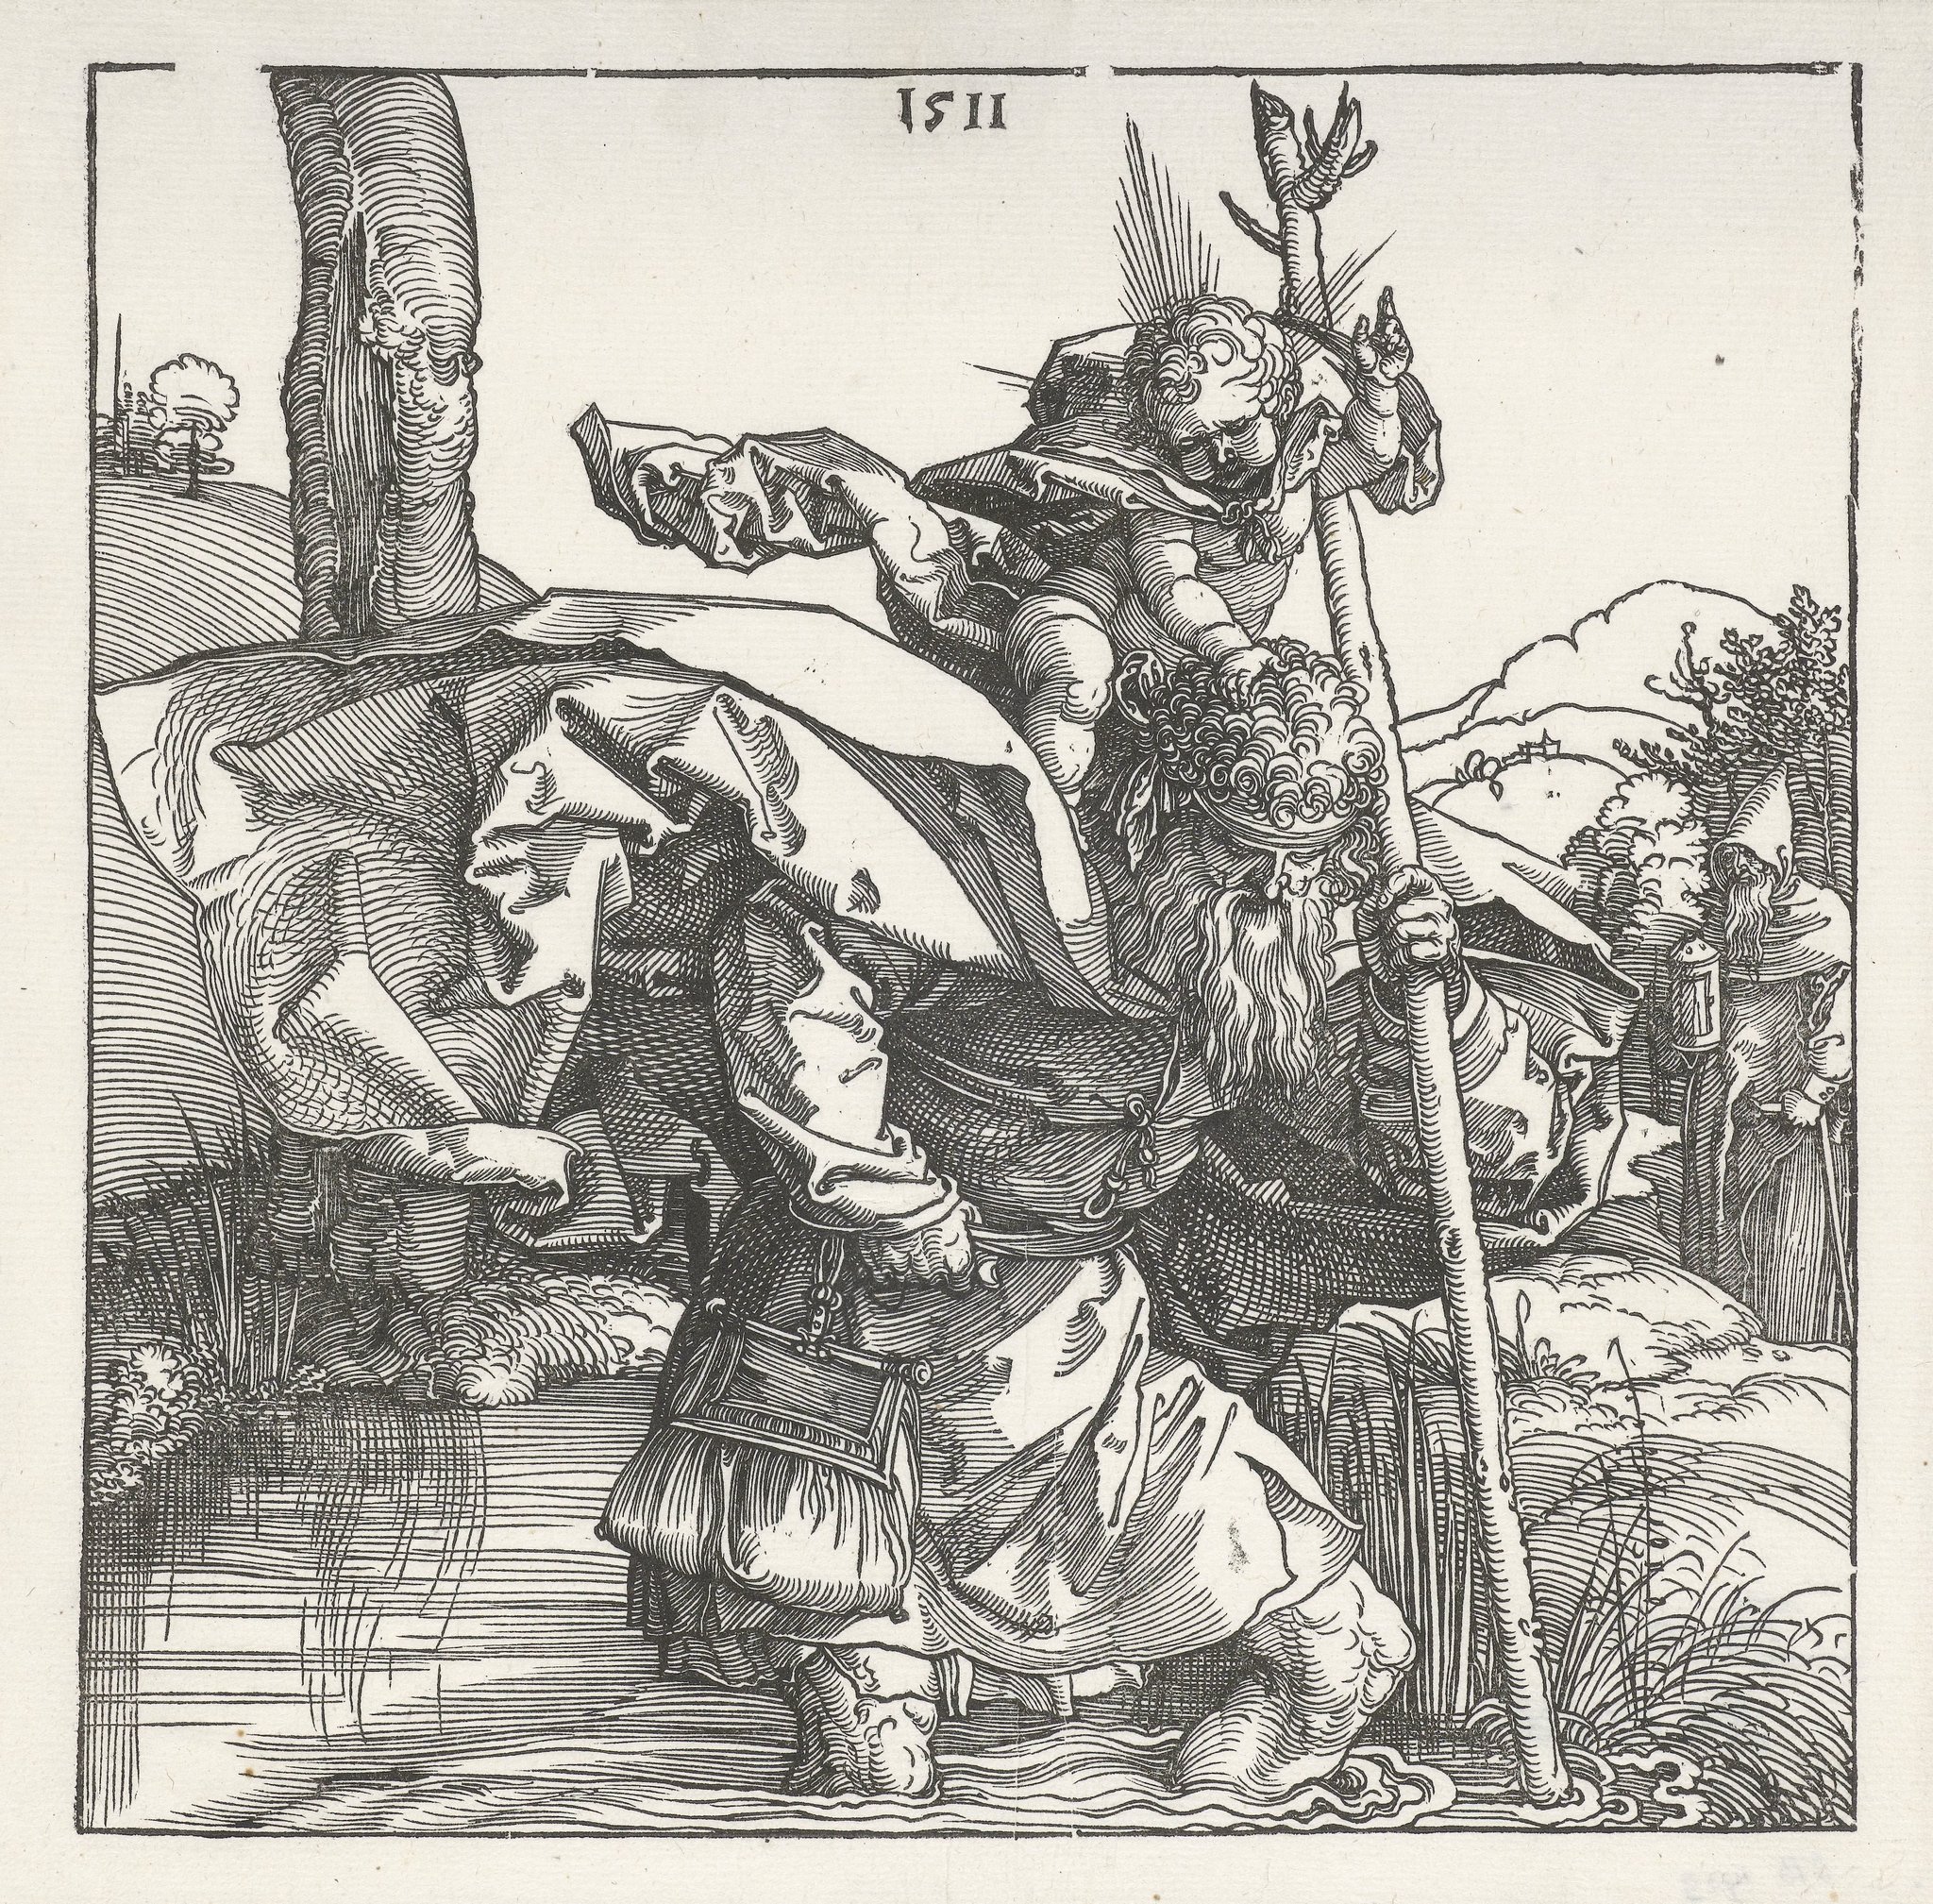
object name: print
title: De Heilige Christoffel draagt het Christuskind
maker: albrecht dürer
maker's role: draughtsman, painter, print maker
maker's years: 1471-1528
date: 1511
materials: paper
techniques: woodcut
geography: nuremberg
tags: st. christopher, with the infant christ on his shoulders, wading through the water and carrying his staff (palm-tree); sometimes a hermit stands on the further bank beside a chapel, a lantern in his hand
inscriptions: collector's mark: Lugt 2228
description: De Heilige Christoffel waadt door een rivier met een stok in zijn linkerhand en het Christuskind op zijn schouders. Aan de oever staat een kluizenaar met een lamp.